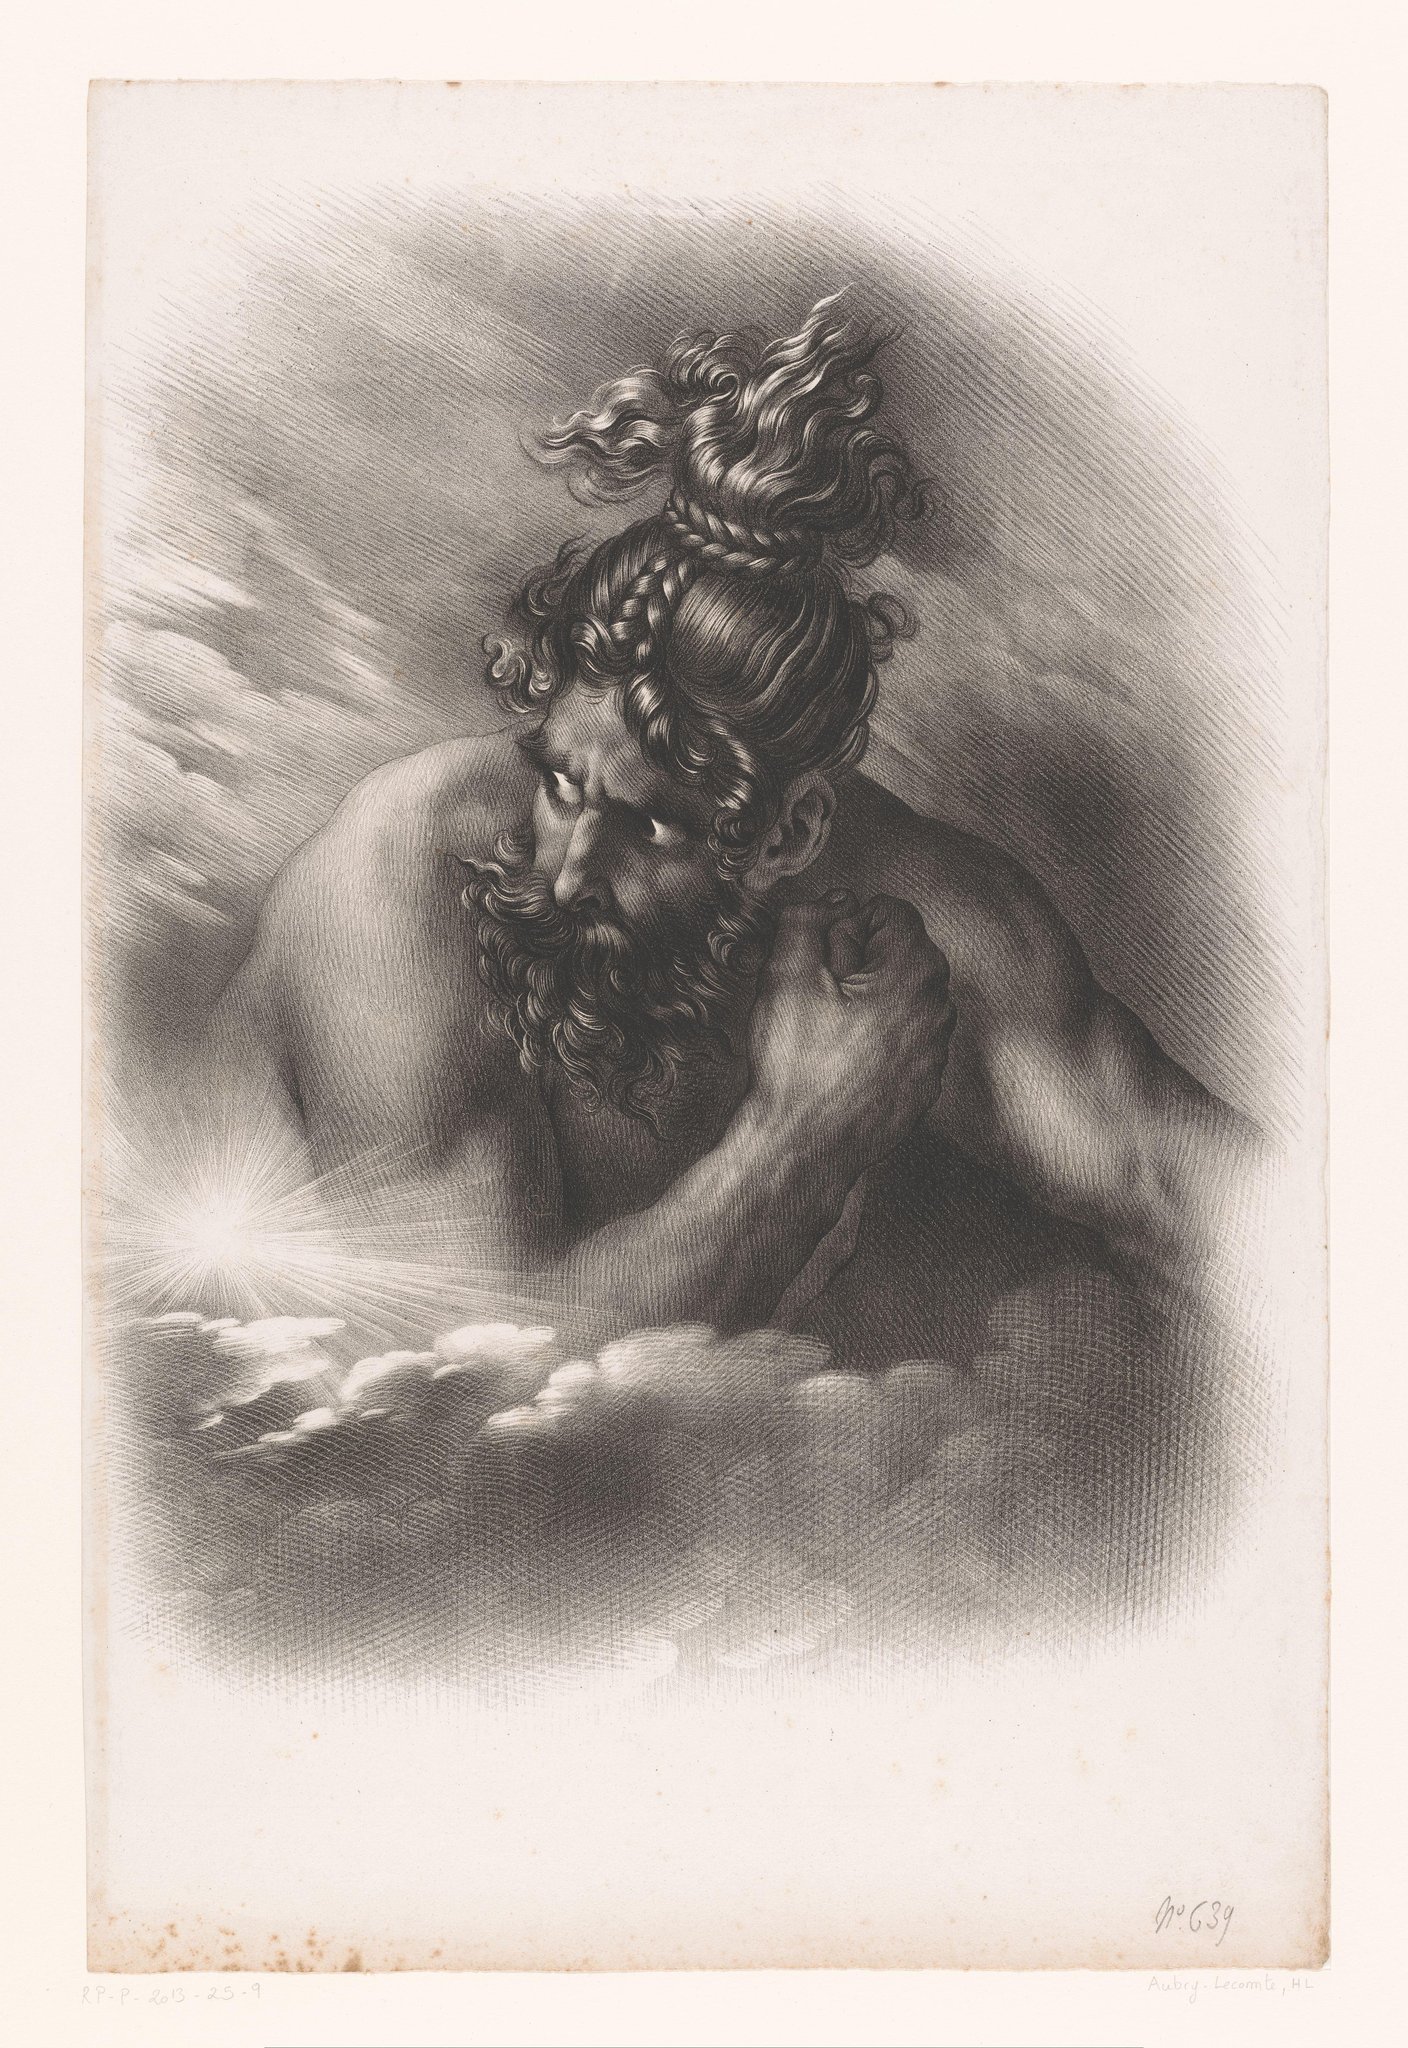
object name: print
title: Swaran, de verslagen koning van Lochlin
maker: hyacinthe louis victor jean baptiste aubry-lecomte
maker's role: print maker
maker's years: 1787-1858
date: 1821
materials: paper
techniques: lithograph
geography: france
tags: (scenes from) specific works of literature (with author, title)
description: Swaran is een figuur uit de epische gedichten van Ossian.